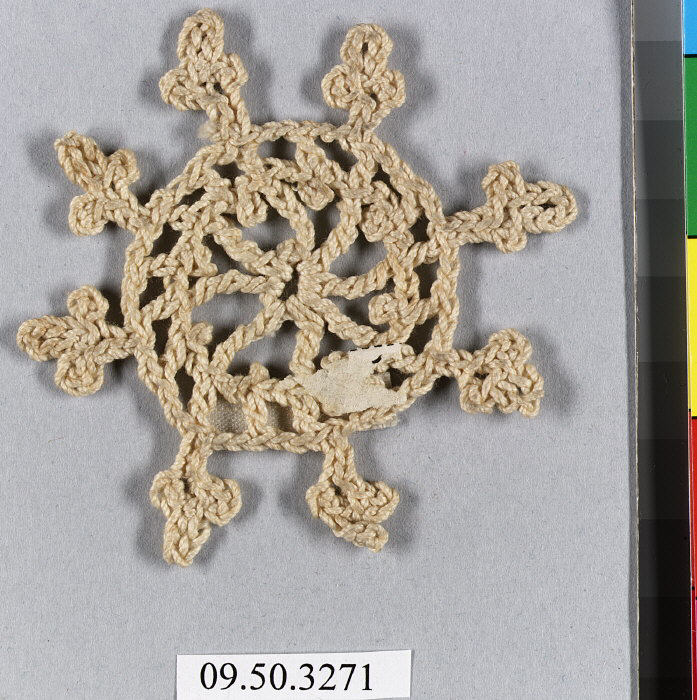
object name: sample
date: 1801-1900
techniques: crochet